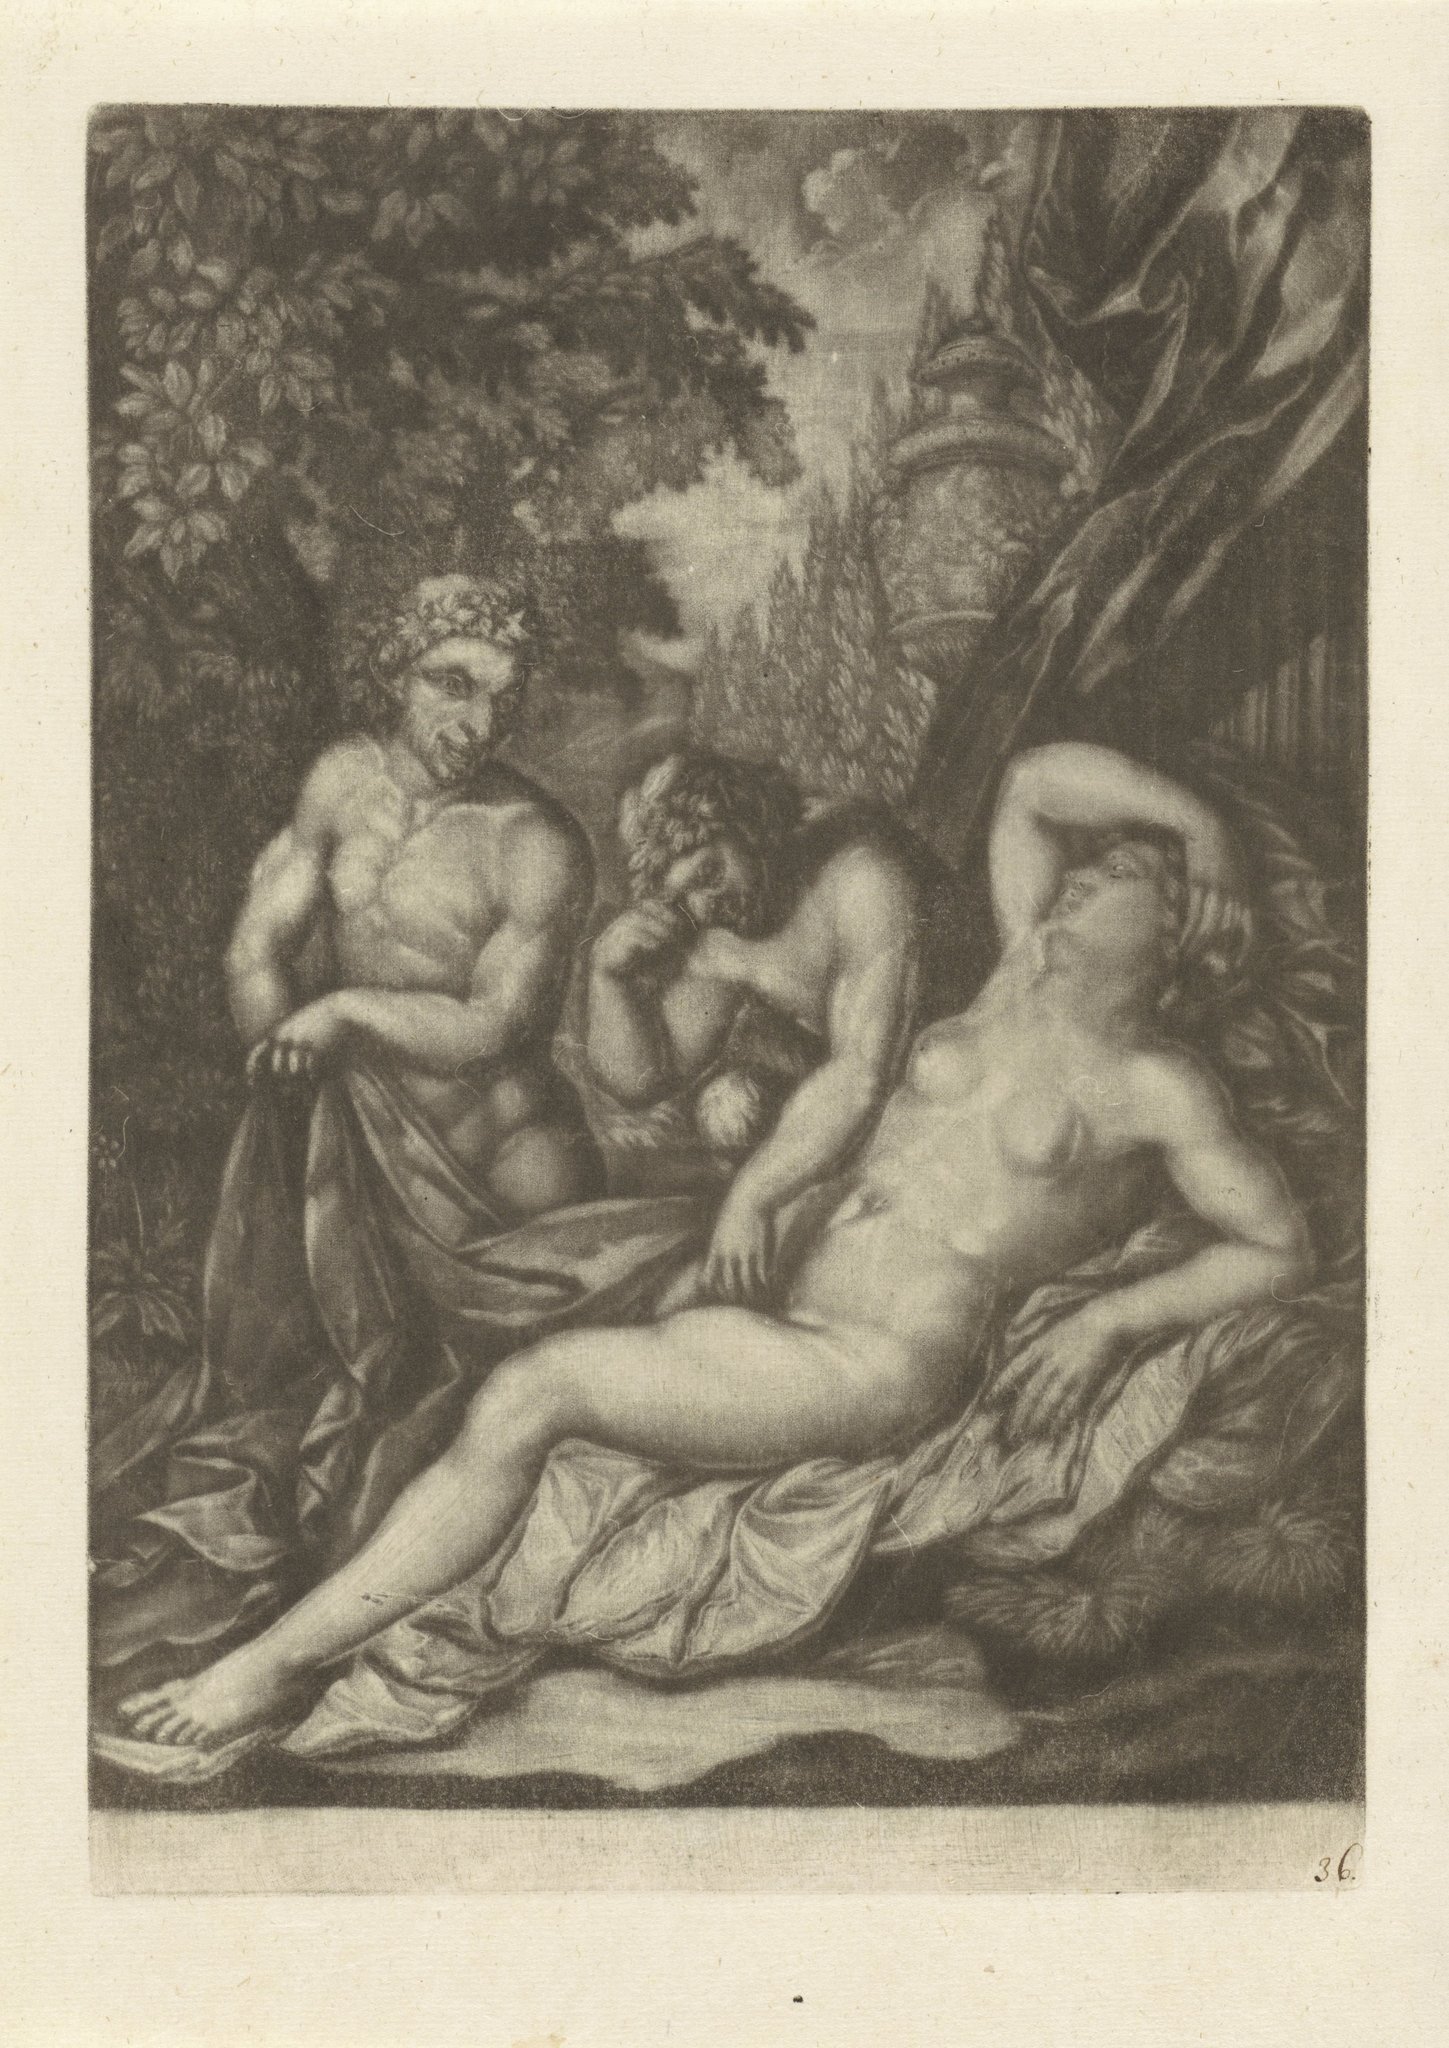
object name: print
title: Twee saters bij een slapende nimf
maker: jan van somer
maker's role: draughtsman, print maker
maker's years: 1645-1699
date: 1655-1700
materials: paper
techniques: mezzotint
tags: nymphs (in general); 'ninfe in commune' (ripa), satyr(s) spying upon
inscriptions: collector's mark: Lugt 2228